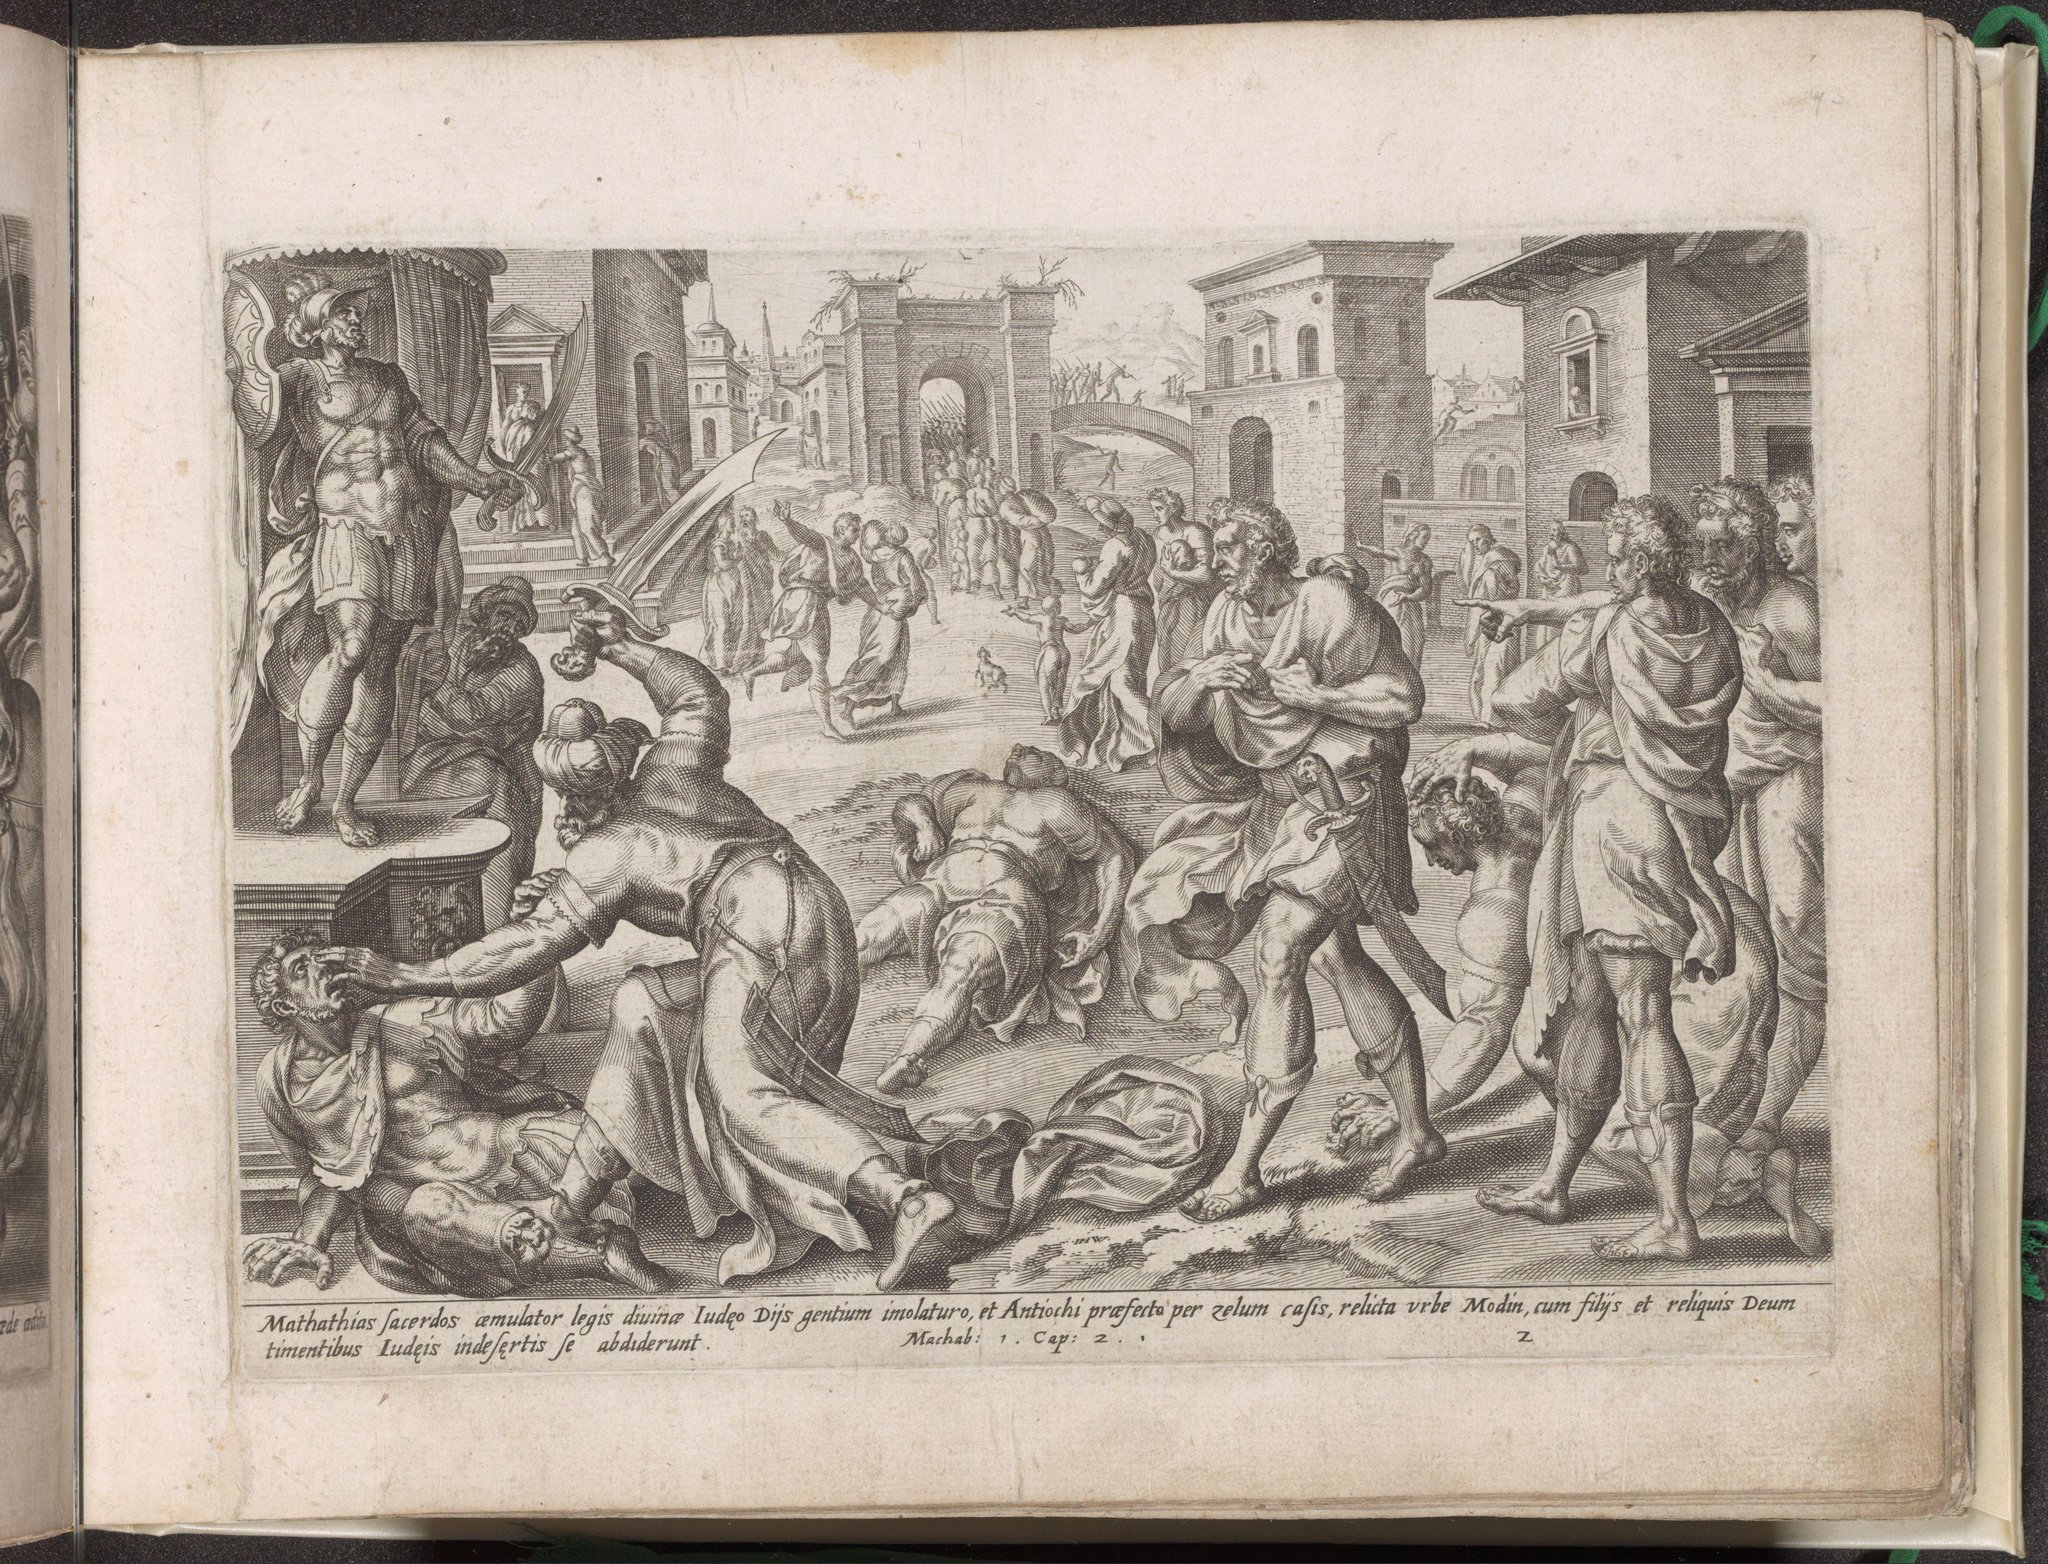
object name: print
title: Geschiedenis van de Makkabeeën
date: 1572-1576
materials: paper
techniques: engraving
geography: antwerp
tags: mattathias kills a jew, who wanted to offer sacrifices to pagan gods, and pulls down the altar in modin (1 maccabees 2:23-26)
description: Mattatias doodt een Jood die overeenkomstig het bevel van de koning een offer wilde brengen op het altaar in Modeïn en de afgezant van de koning. Zo toonde hij zijn toewijding aan de wet van God. Onder de voorstelling een verwijzing in het Latijn naar de Bijbeltekst in 1 Makk. 2. Deze prent maakt deel uit van een album.